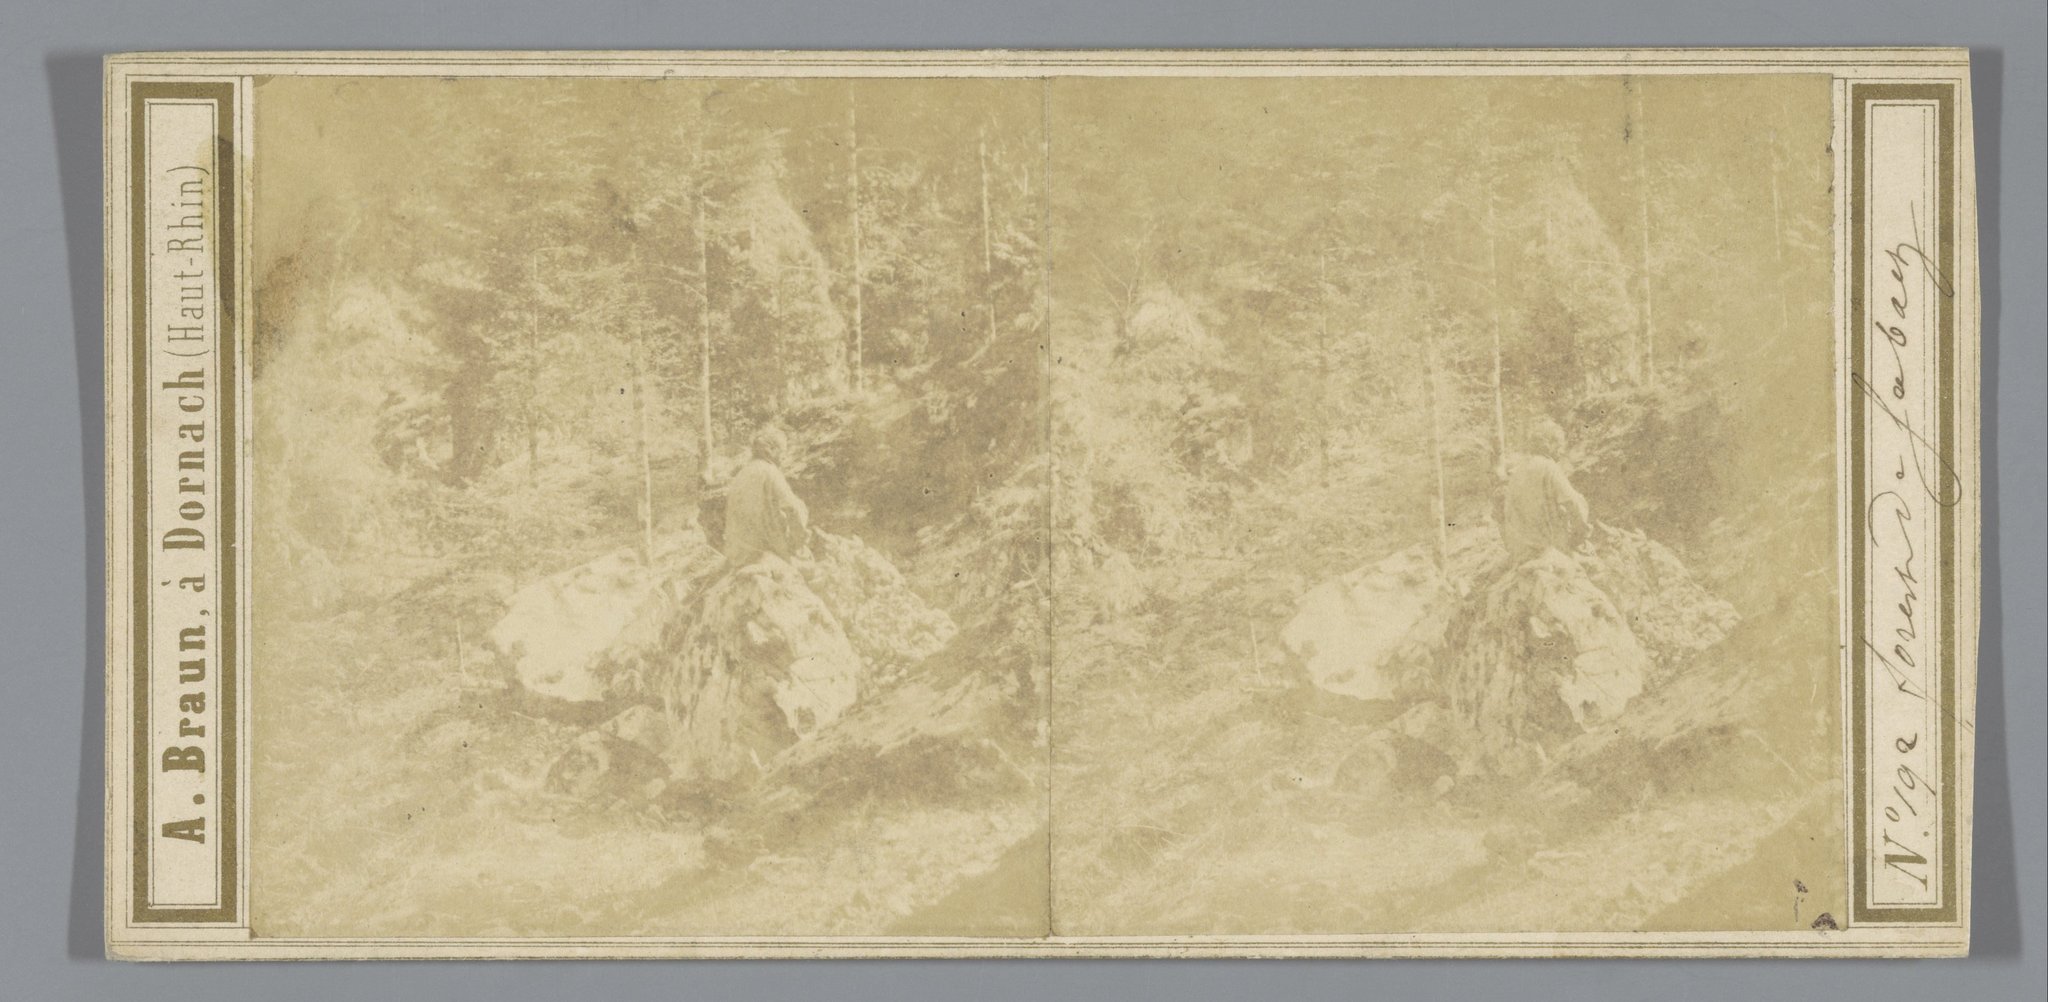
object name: stereograph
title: Man in een bos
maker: Anonymous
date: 1860-1866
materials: cardboard, paper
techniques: albumen print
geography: dornach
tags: forest, wood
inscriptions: number: ‘No. 192’